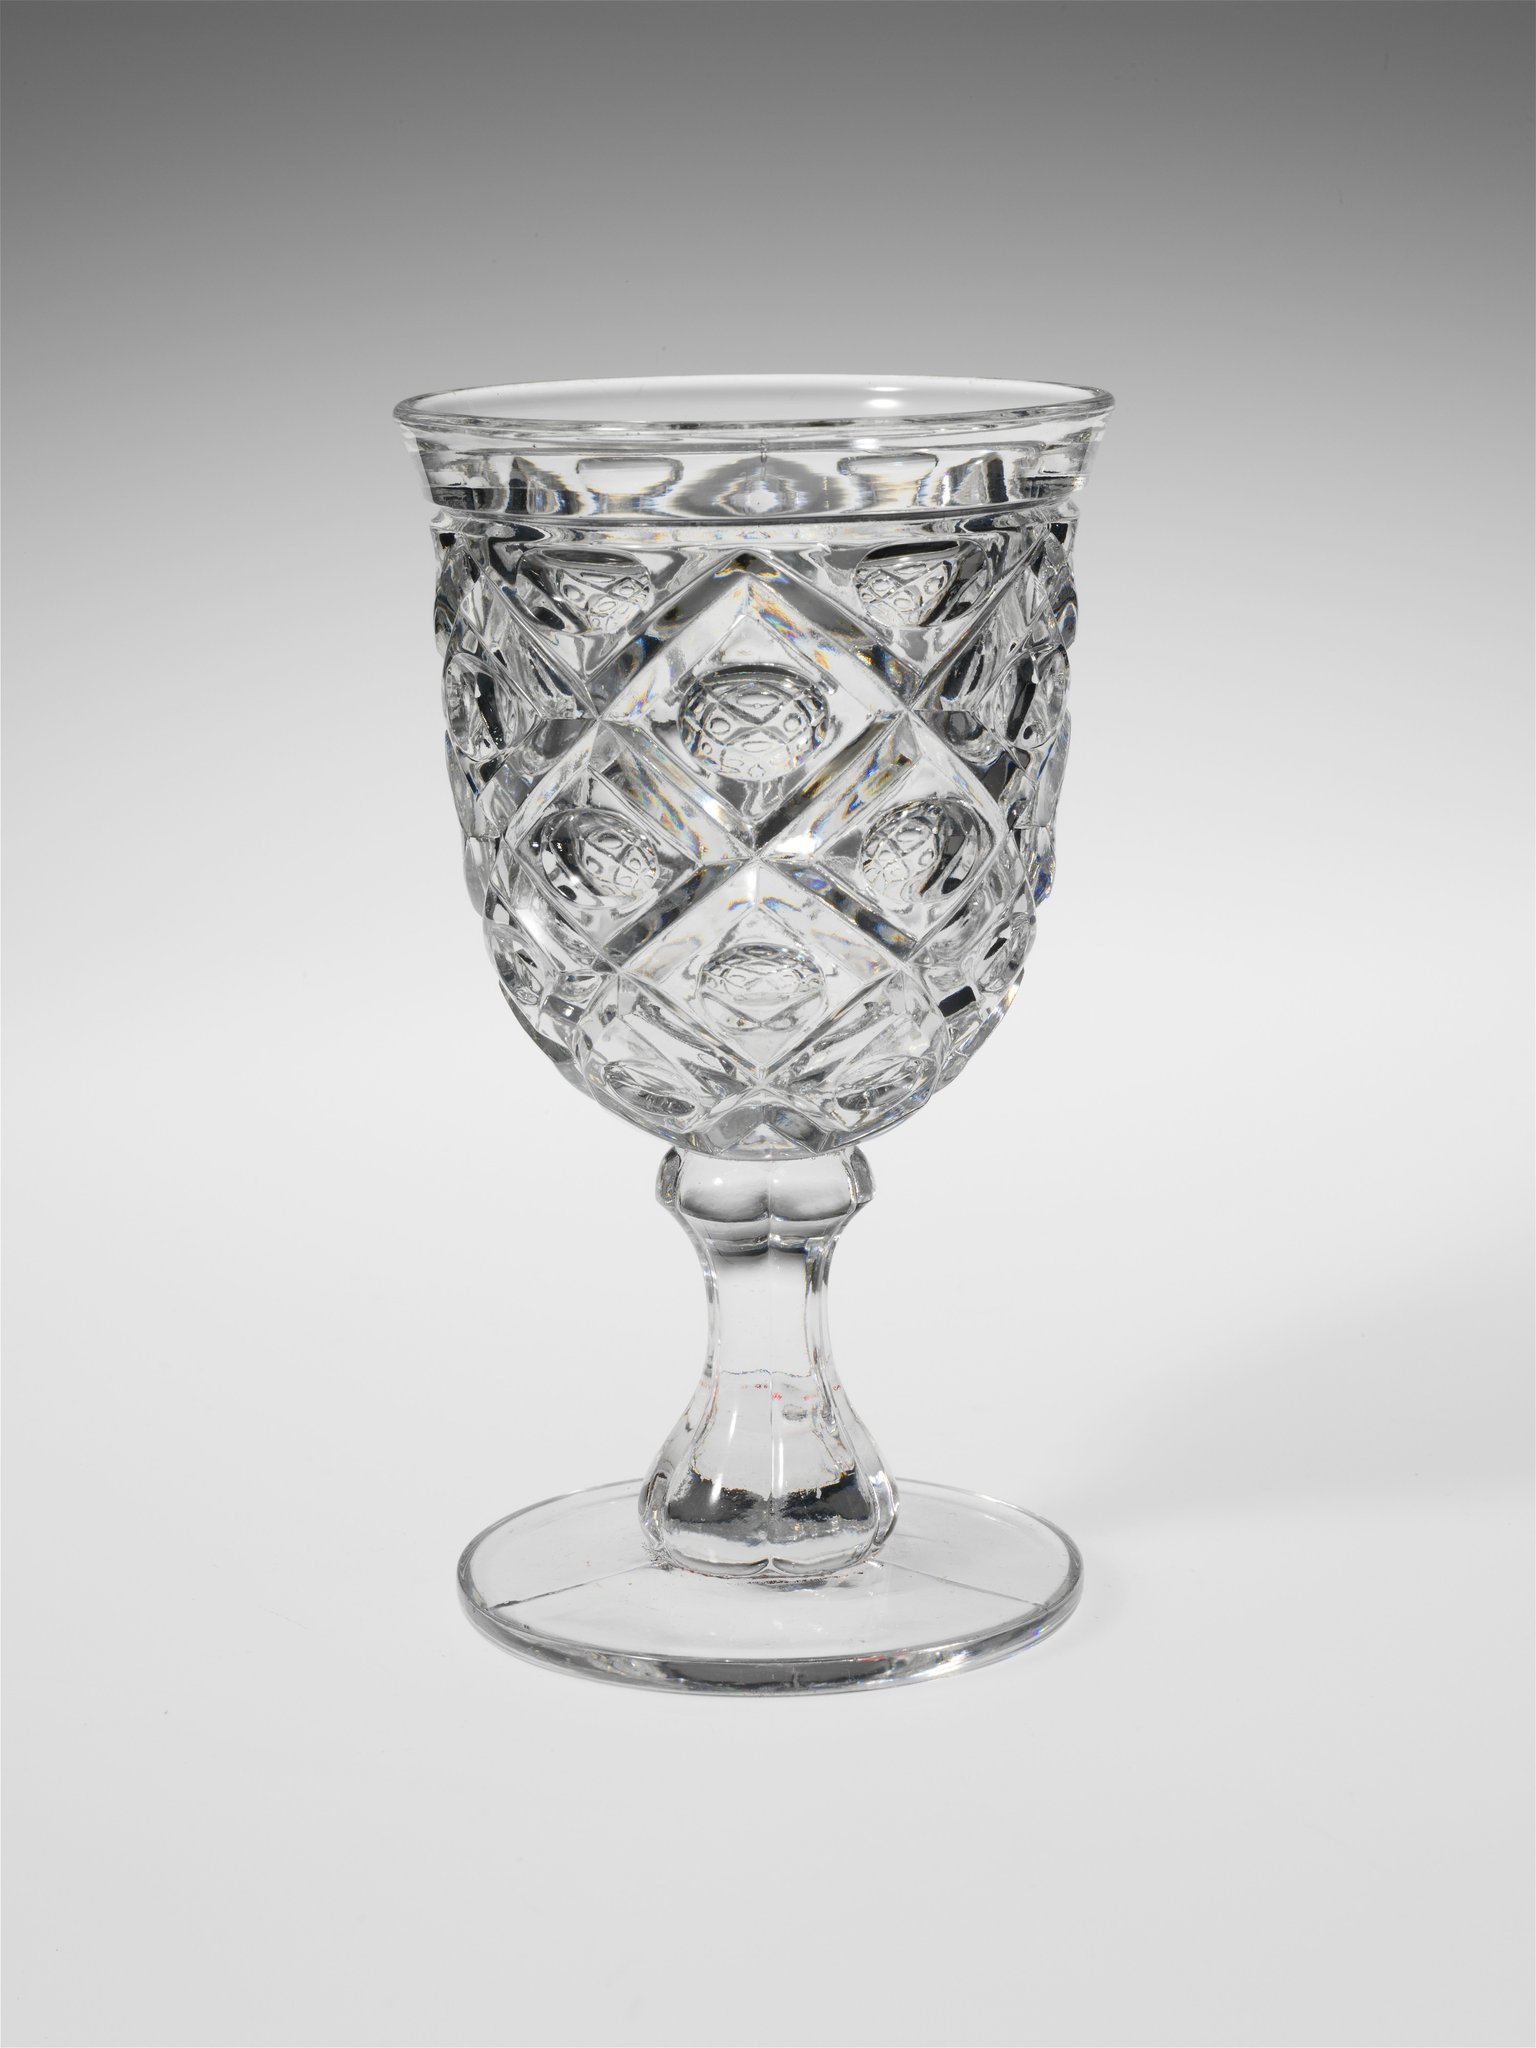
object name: goblet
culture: american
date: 1850-1860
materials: diamond, glass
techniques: pressed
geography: united states